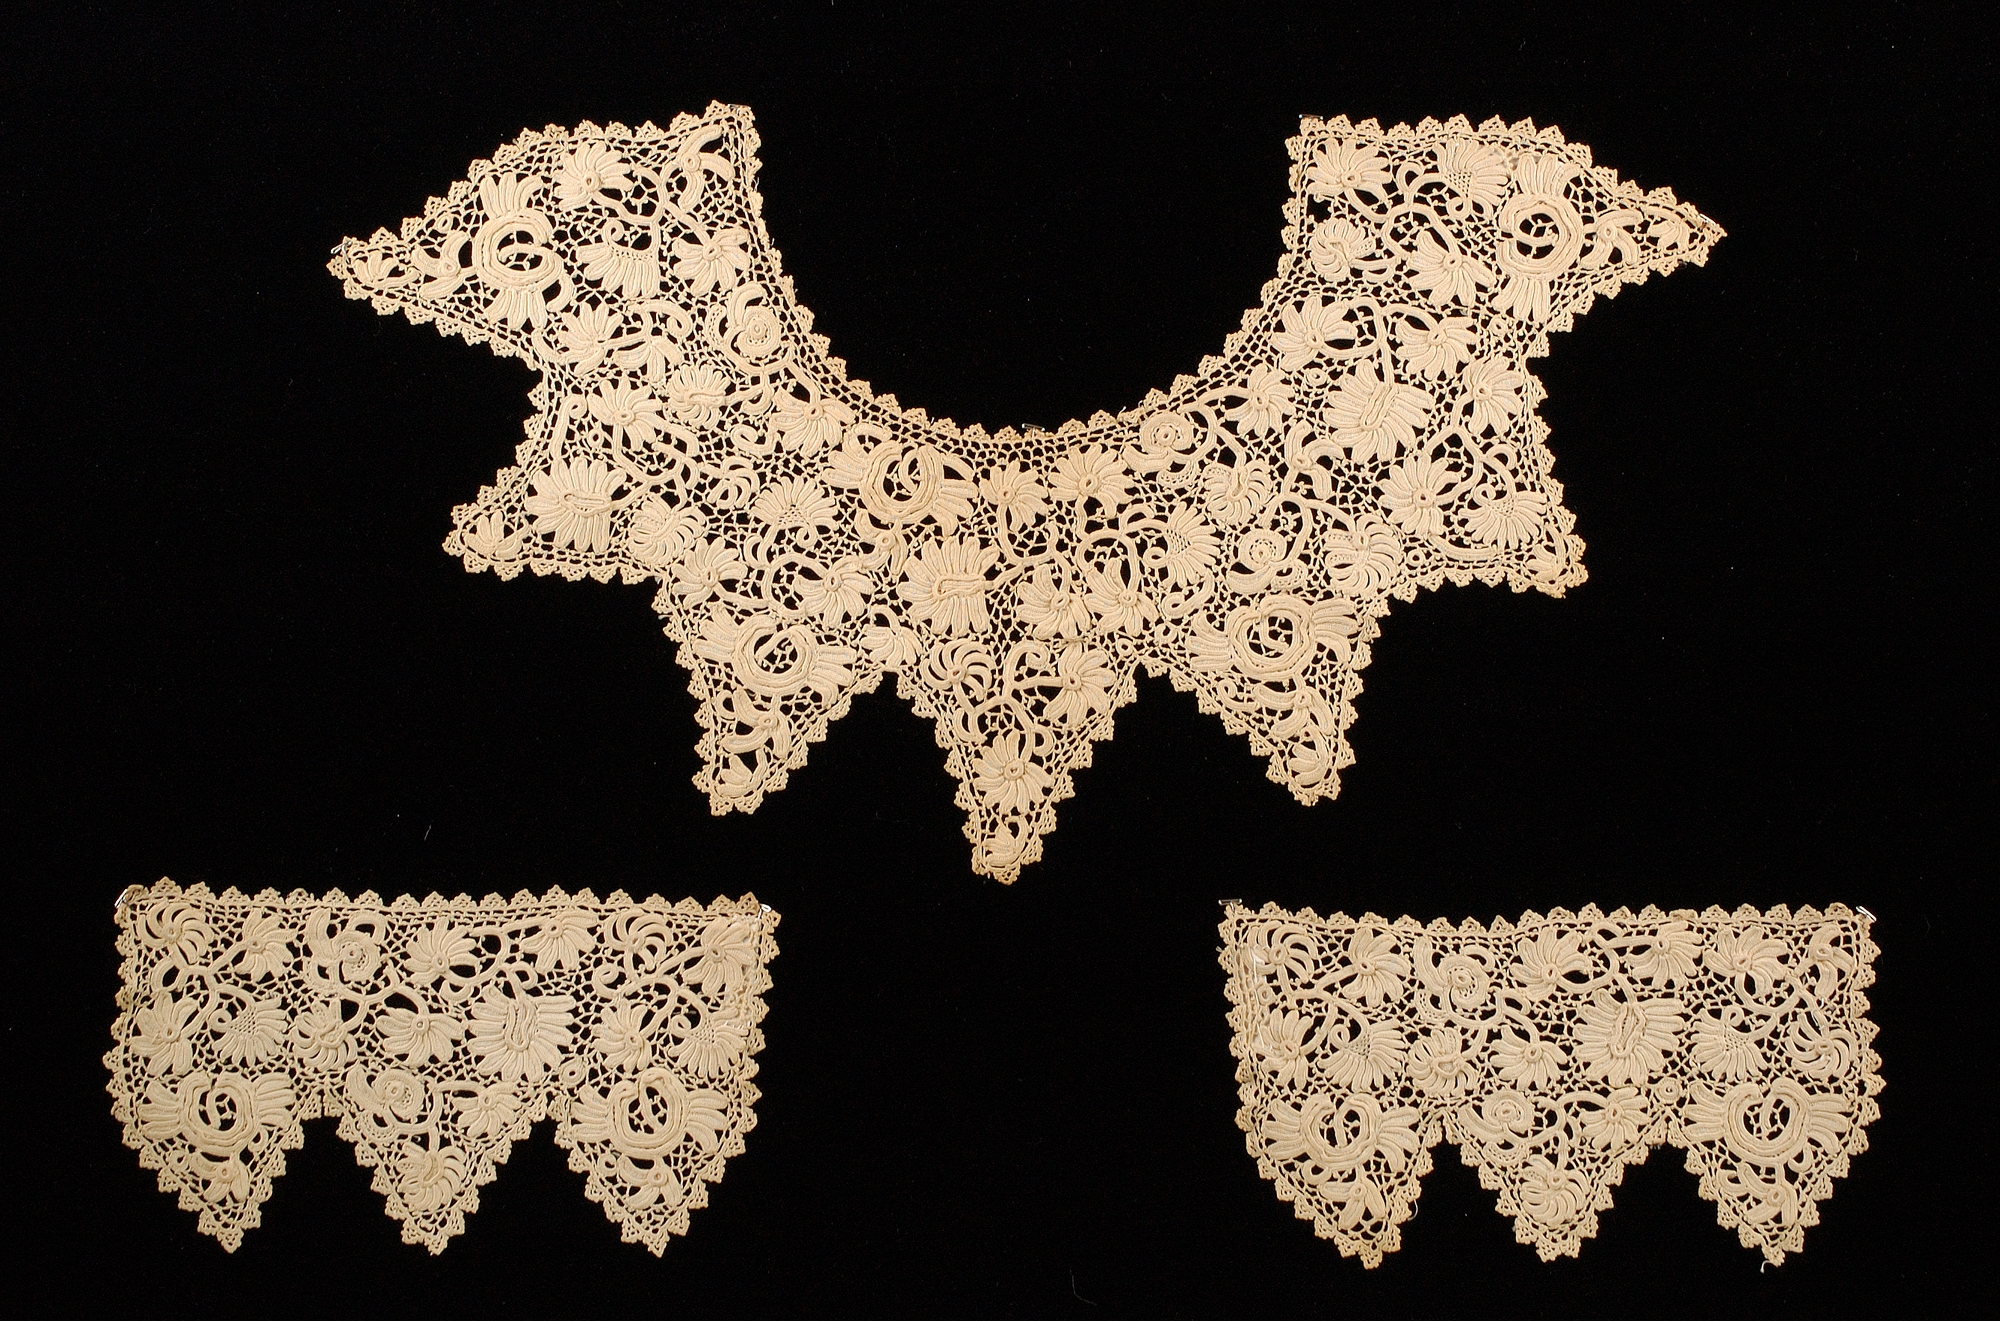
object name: accessory set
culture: irish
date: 1890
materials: cotton